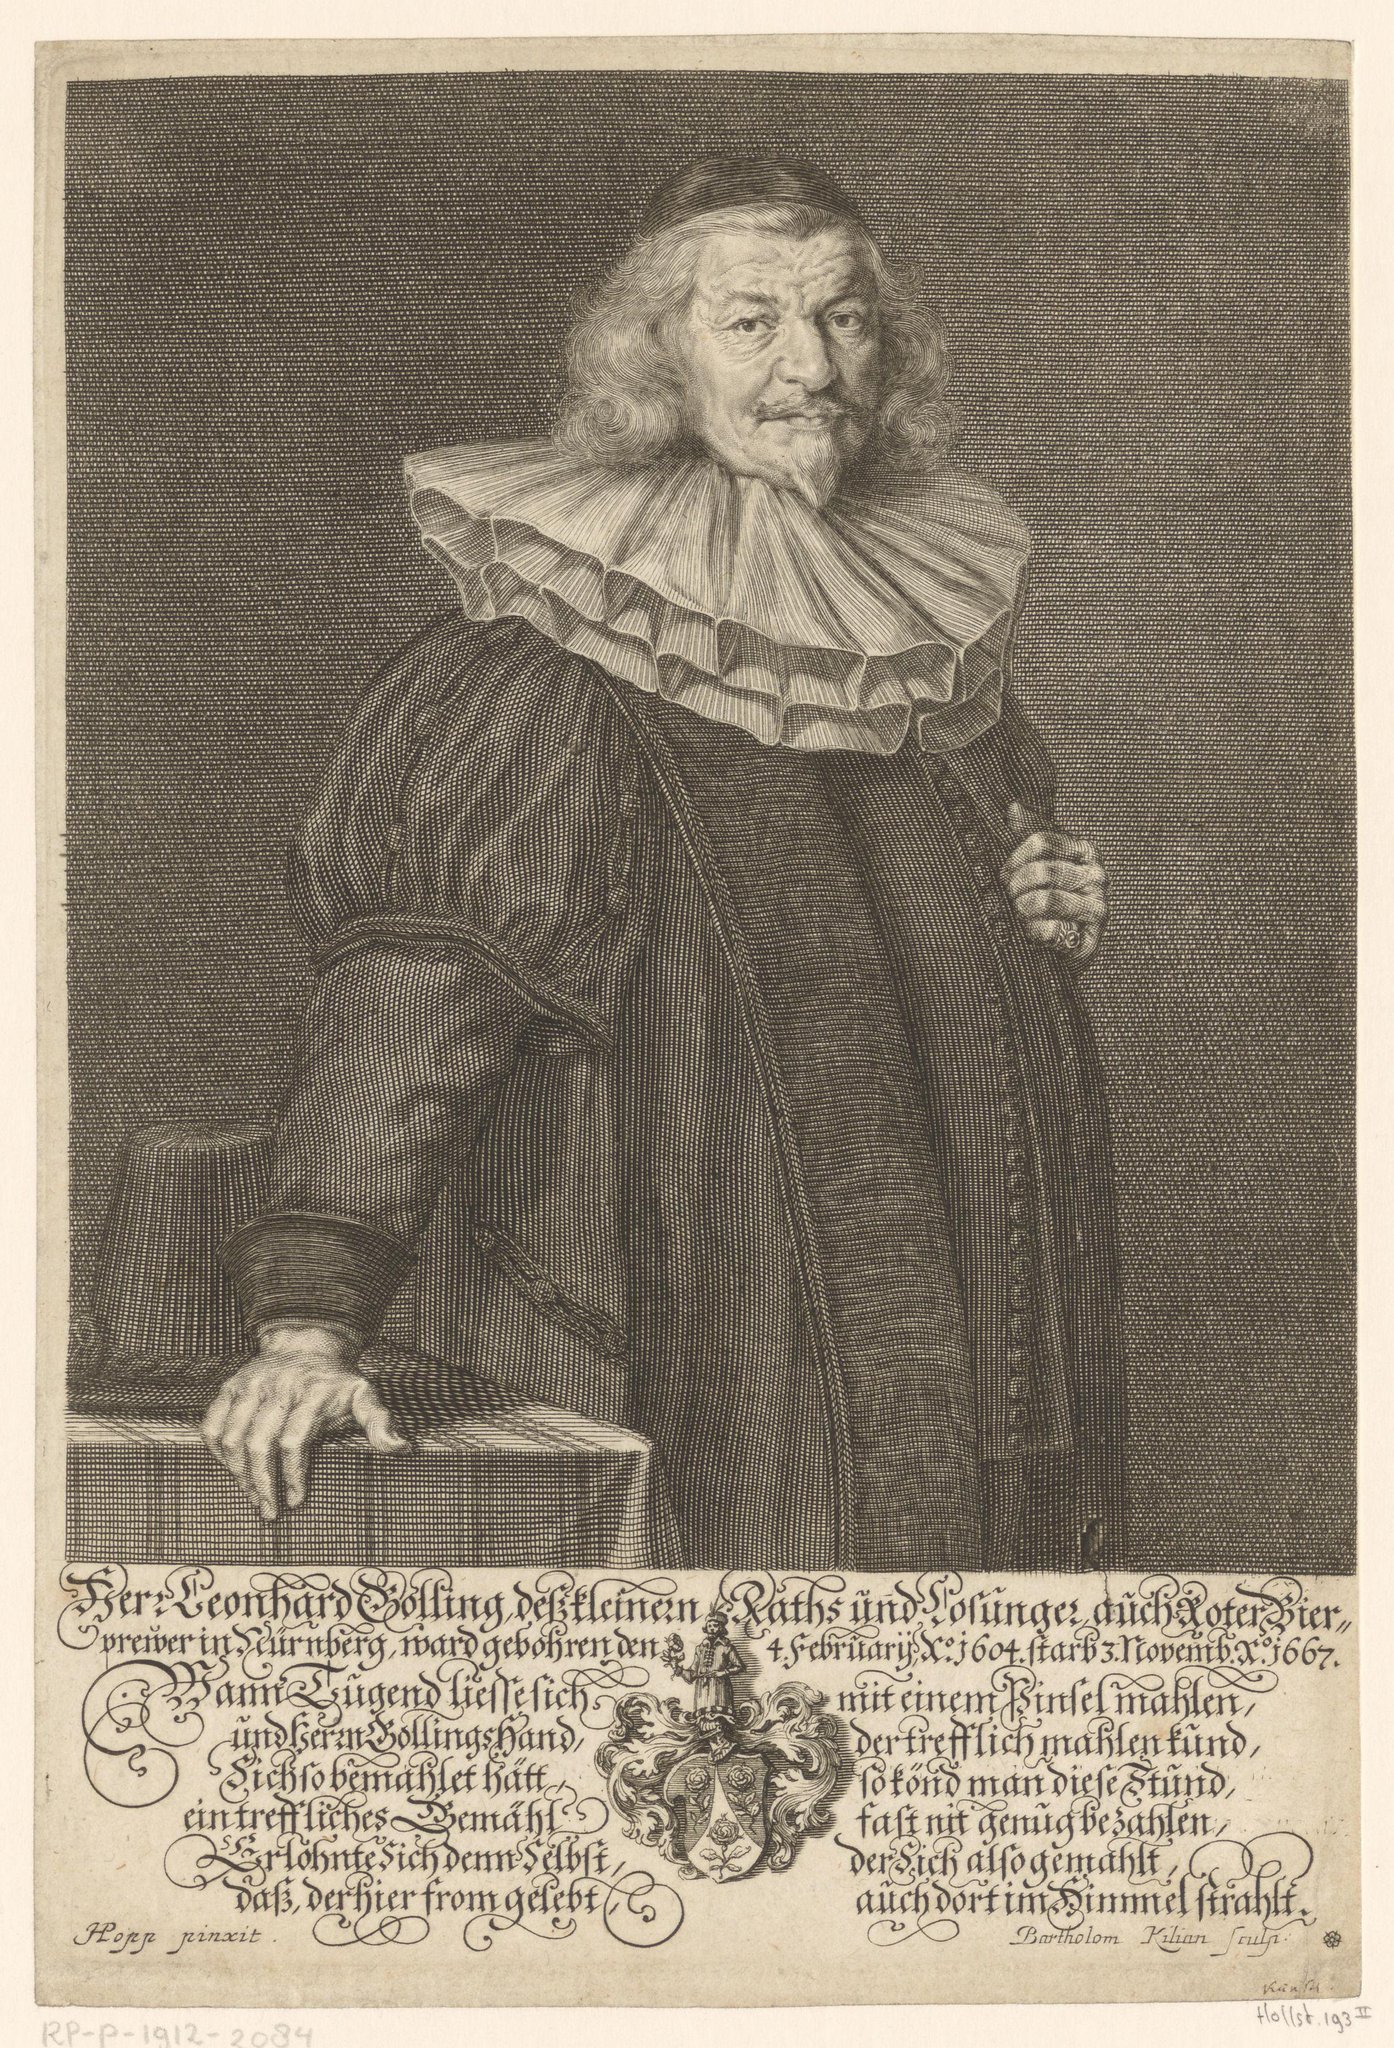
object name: print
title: Portret van Leonhard Golling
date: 1667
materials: paper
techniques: engraving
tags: historical persons, counsellor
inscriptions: collector's mark: Lugt 2228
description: Tekst in het Duits in de marge onderaan.